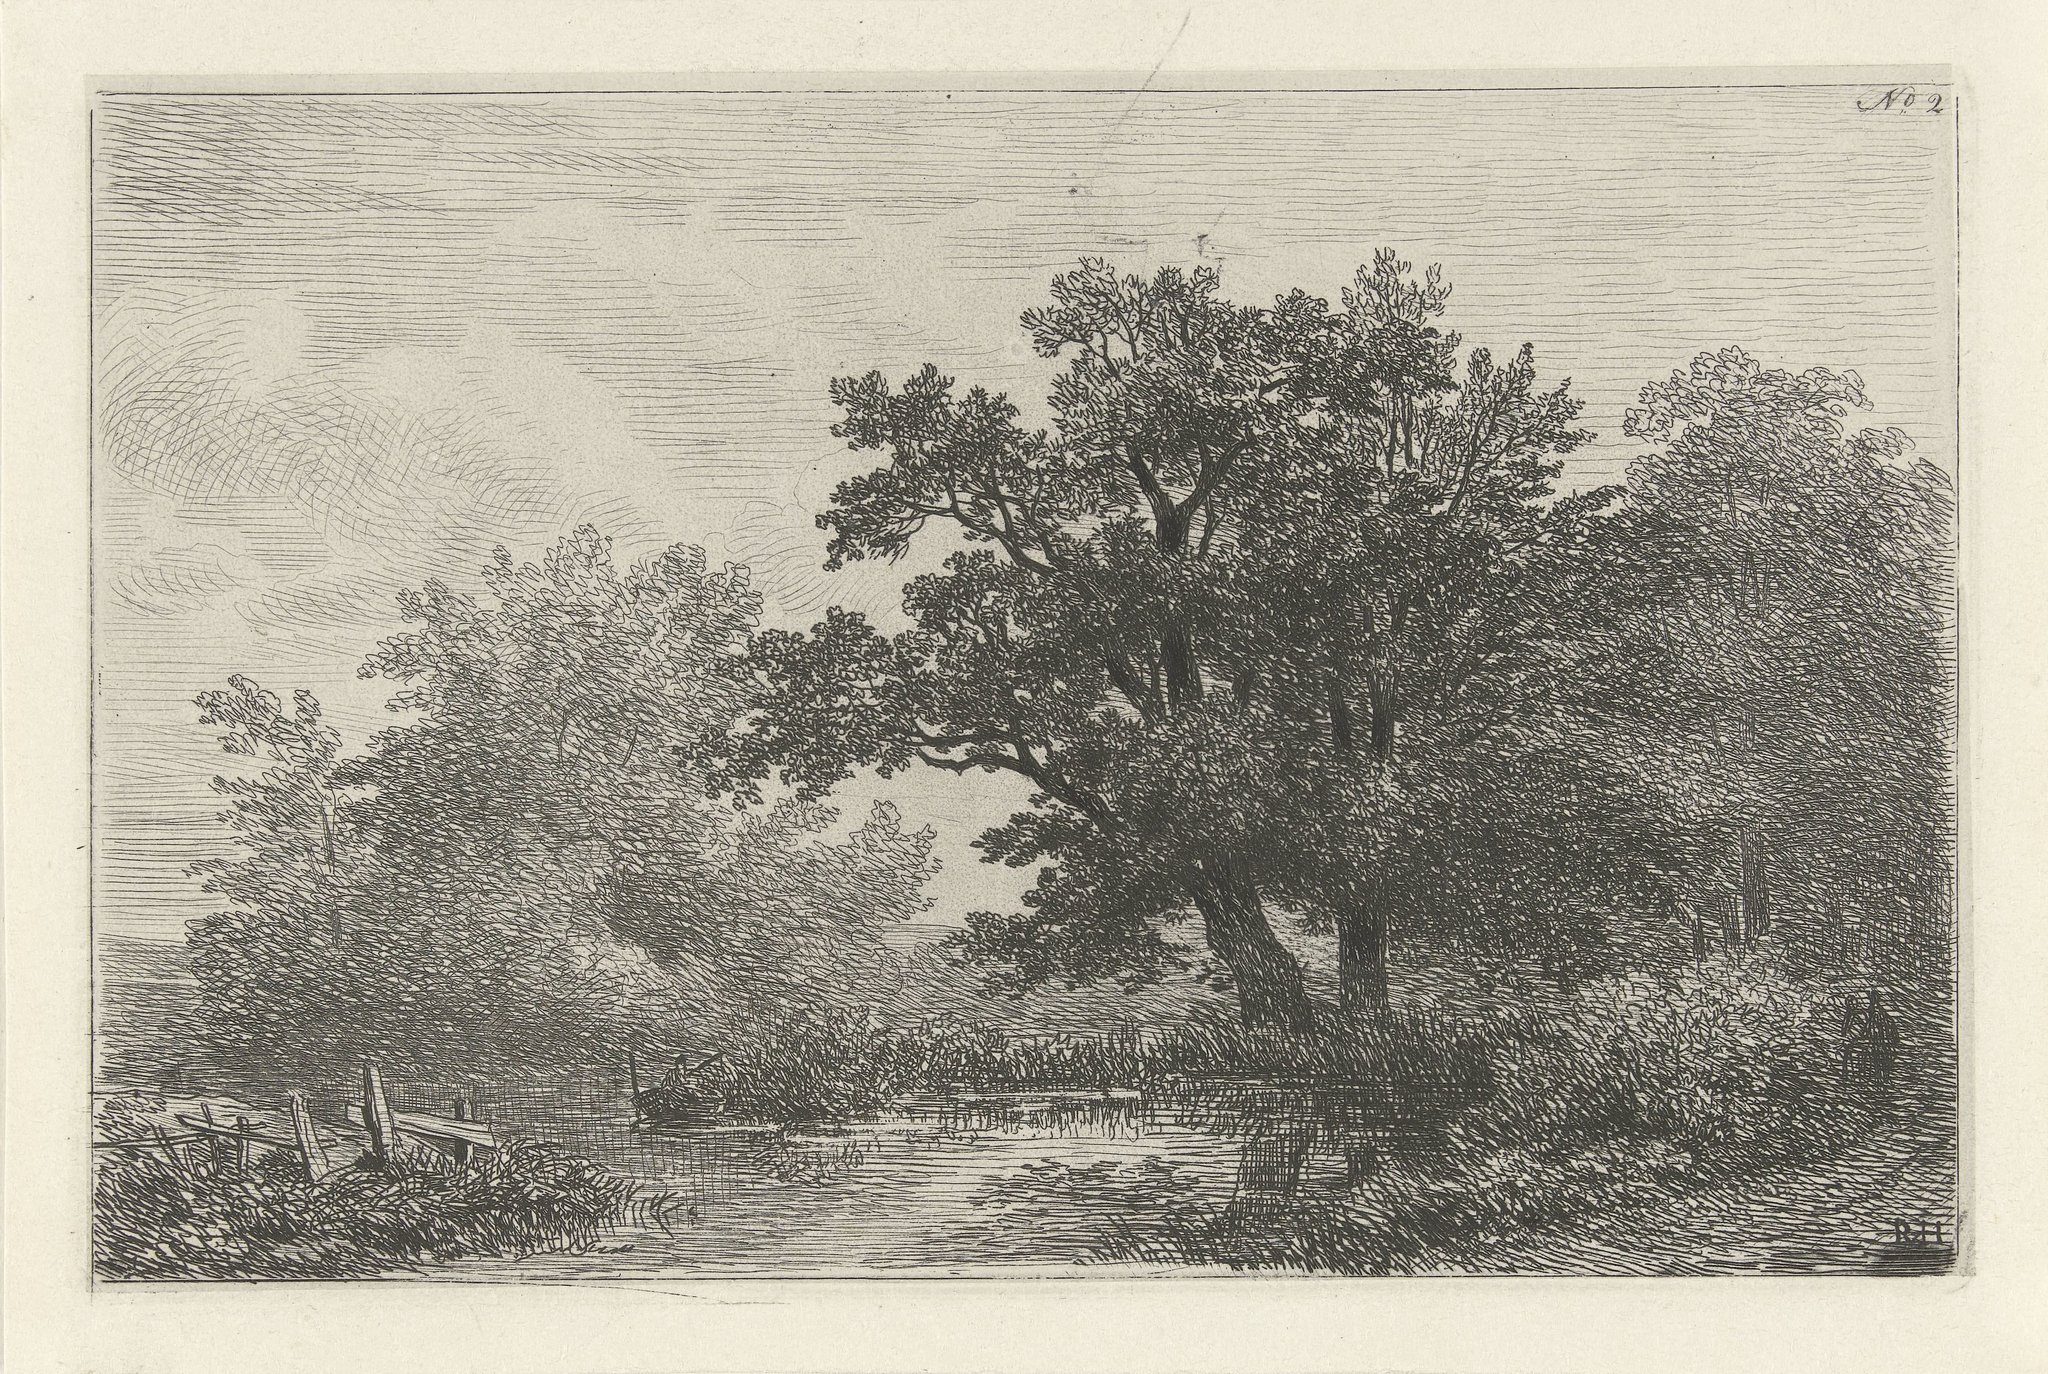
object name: print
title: Bomen aan een plas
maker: remigius adrianus haanen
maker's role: draughtsman, painter, print maker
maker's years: 1812-1894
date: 1827-1888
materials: paper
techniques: etching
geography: austria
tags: landscapes with waters, waterscapes, seascapes (in the temperate zone) (+ landscape with figures, staffage)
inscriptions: collector's mark: Lugt 2228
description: Deze prent is genummerd No.2 rechtsboven en zou om die reden een prent kunnen zijn uit de serie van zes waarvan het titelblad is beschreven onder RP-P-OB-55.650.